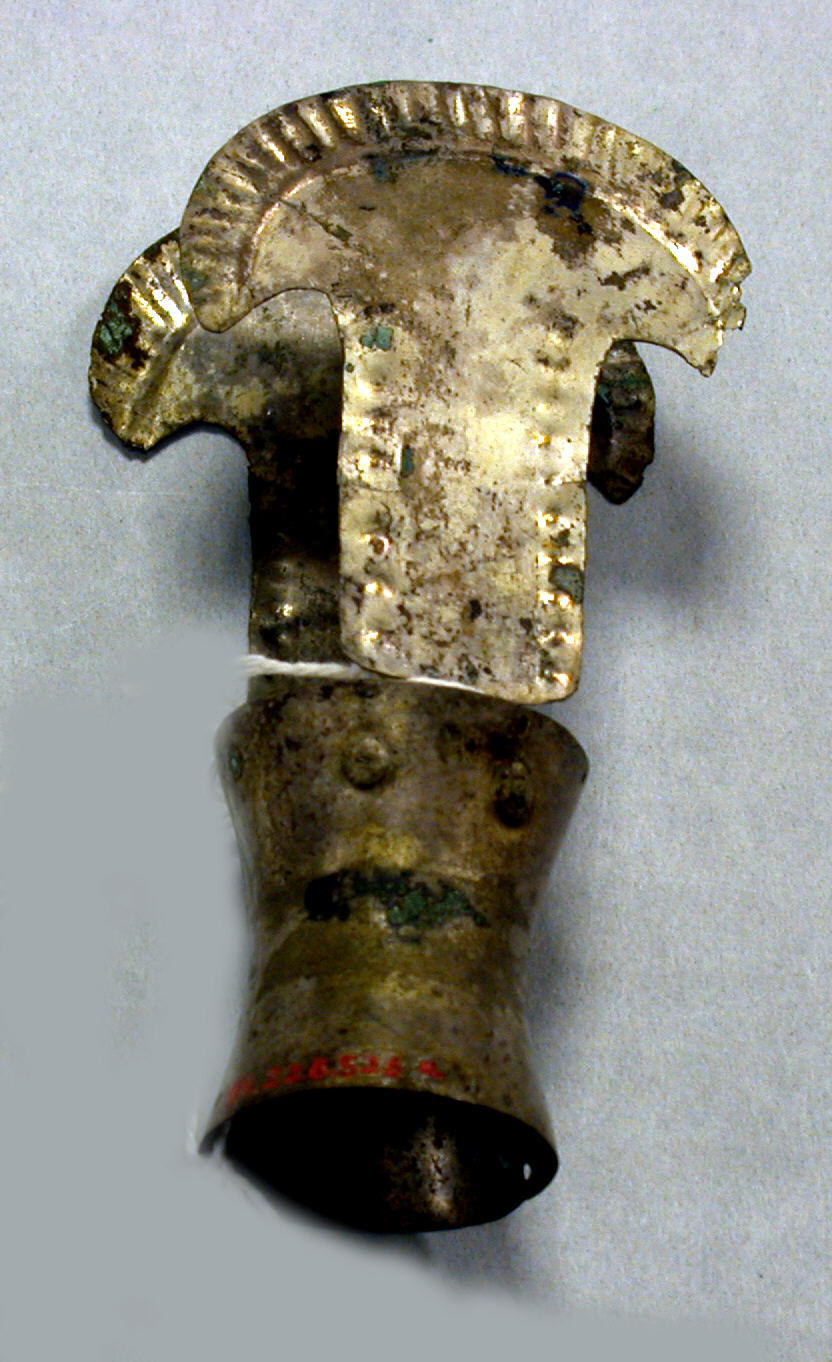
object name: crown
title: Hammered Silver Miniature Crown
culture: peruvian, north or central coast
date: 1001-1566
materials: gilt, silver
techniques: hammering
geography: peru